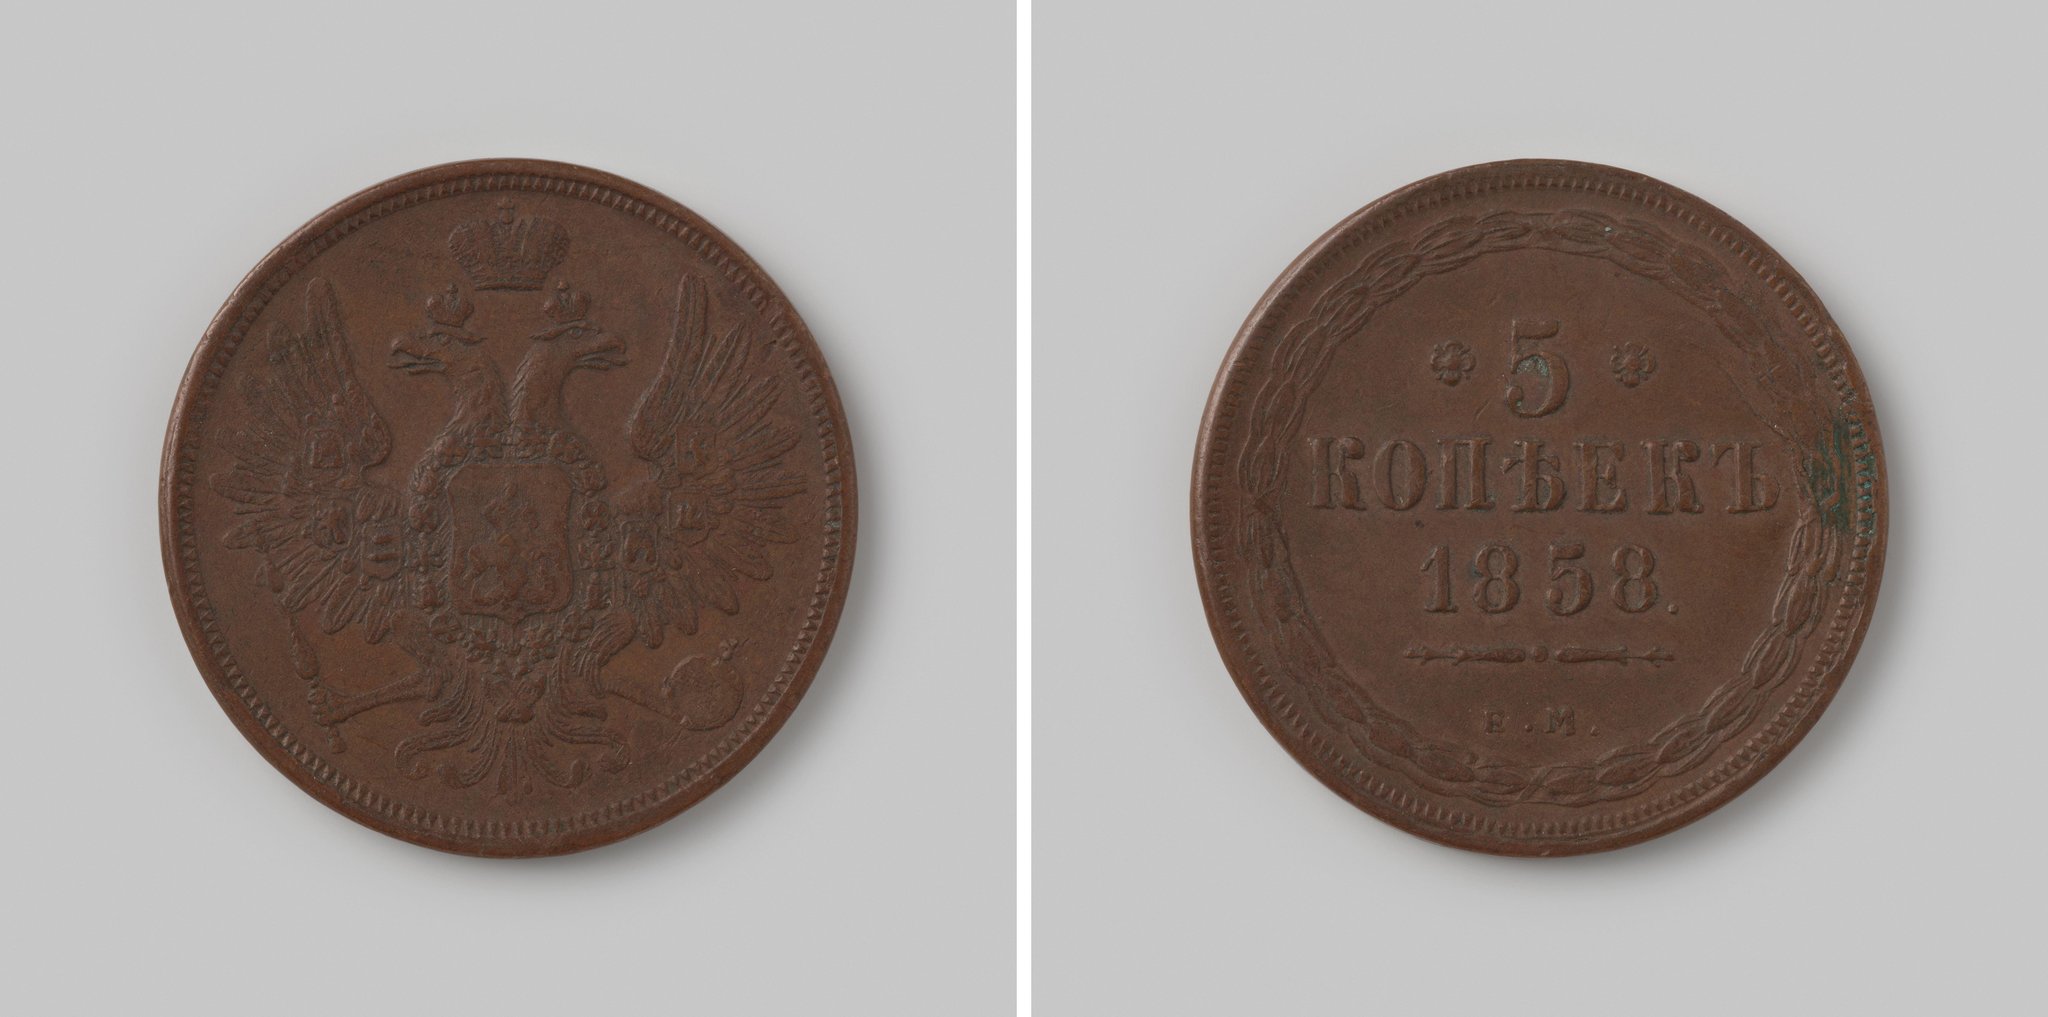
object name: coin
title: Rusland, tsaar Alexander II, 5 kopeken, 1858 EM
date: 1858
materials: copper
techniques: striking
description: Koperen munt. Voorzijde: dubbelkoppige gekroonde adelaar met gespreide vleugels en met op zijn vleugels kleine wapenschilden en op zijn borst een groot, met een ridderorde omhangen wapenschild en in zijn poten een scepter en een gekroonde bol. Boven de adelaar een kroon. Keerzijde: binnen een krans van bladeren in twee regels de waarde-aanduiding, waaronder jaartal. Daaronder in het Cyrillisch de letters E en M [=Ekaterinenburg]. Gladde rand.